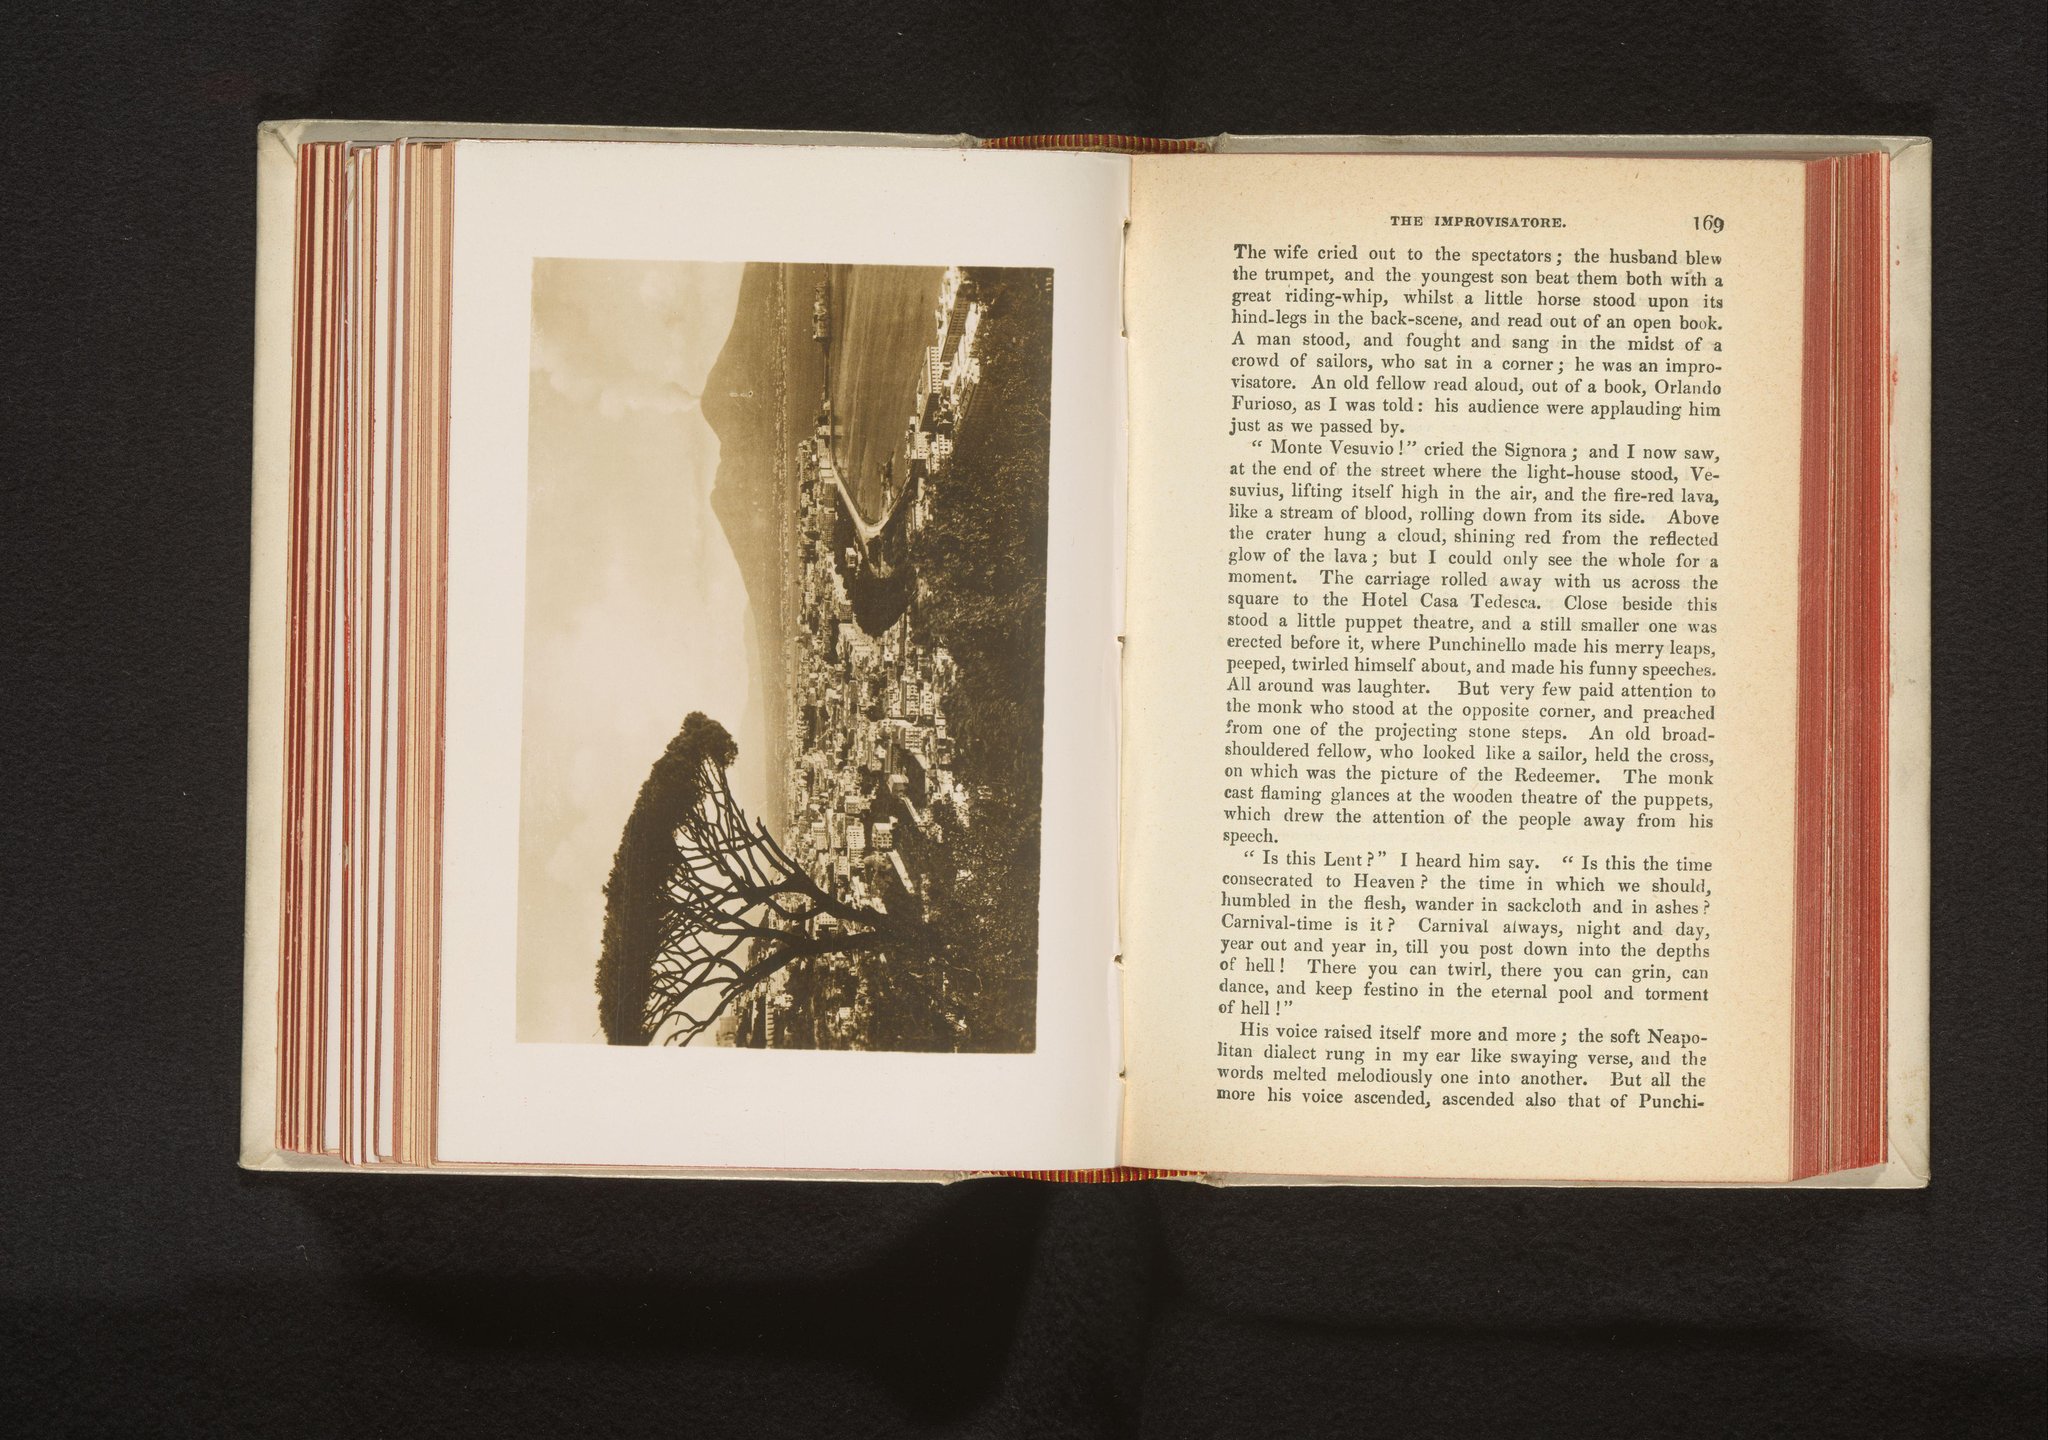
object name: photograph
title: Gezicht op Napels, met op de achtergrond de Vesuvius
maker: Anonymous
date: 1870-1880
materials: photographic support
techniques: gelatin silver print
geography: naples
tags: city-view in general; 'veduta', volcano, mount vesuvius, naples